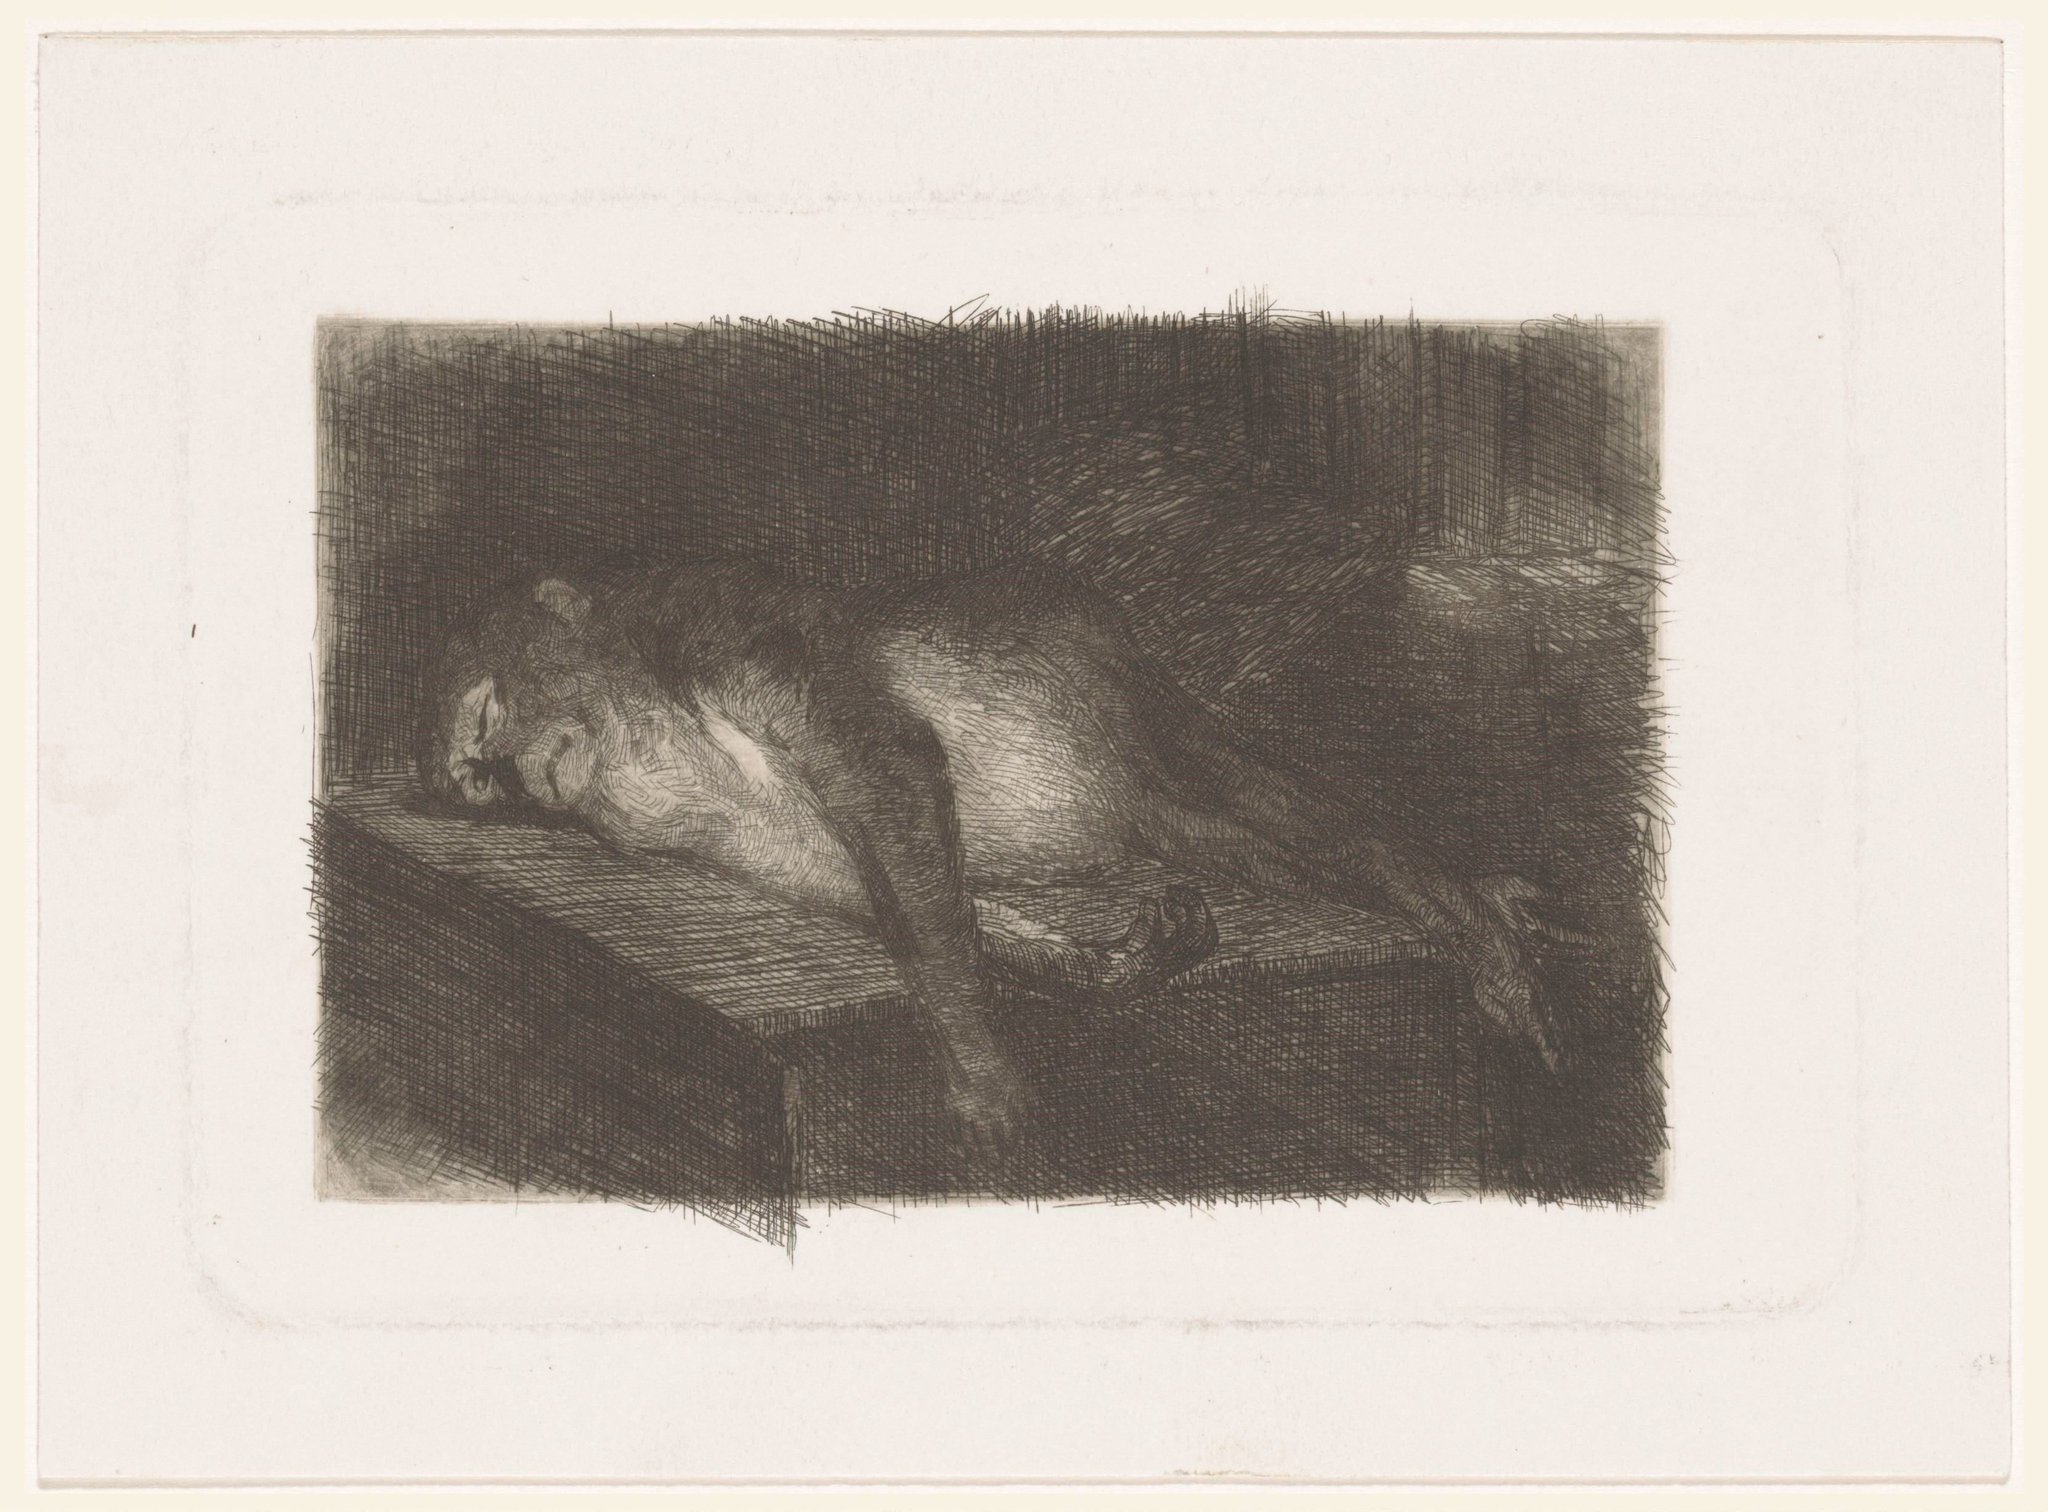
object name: print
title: Liggende, slapende aap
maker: heinrich m. krabbé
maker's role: draughtsman, print maker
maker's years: 1868-1931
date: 1878-1887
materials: paper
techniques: etching, intaglio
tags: monkeys, apes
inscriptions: collector's mark: Lugt 2228